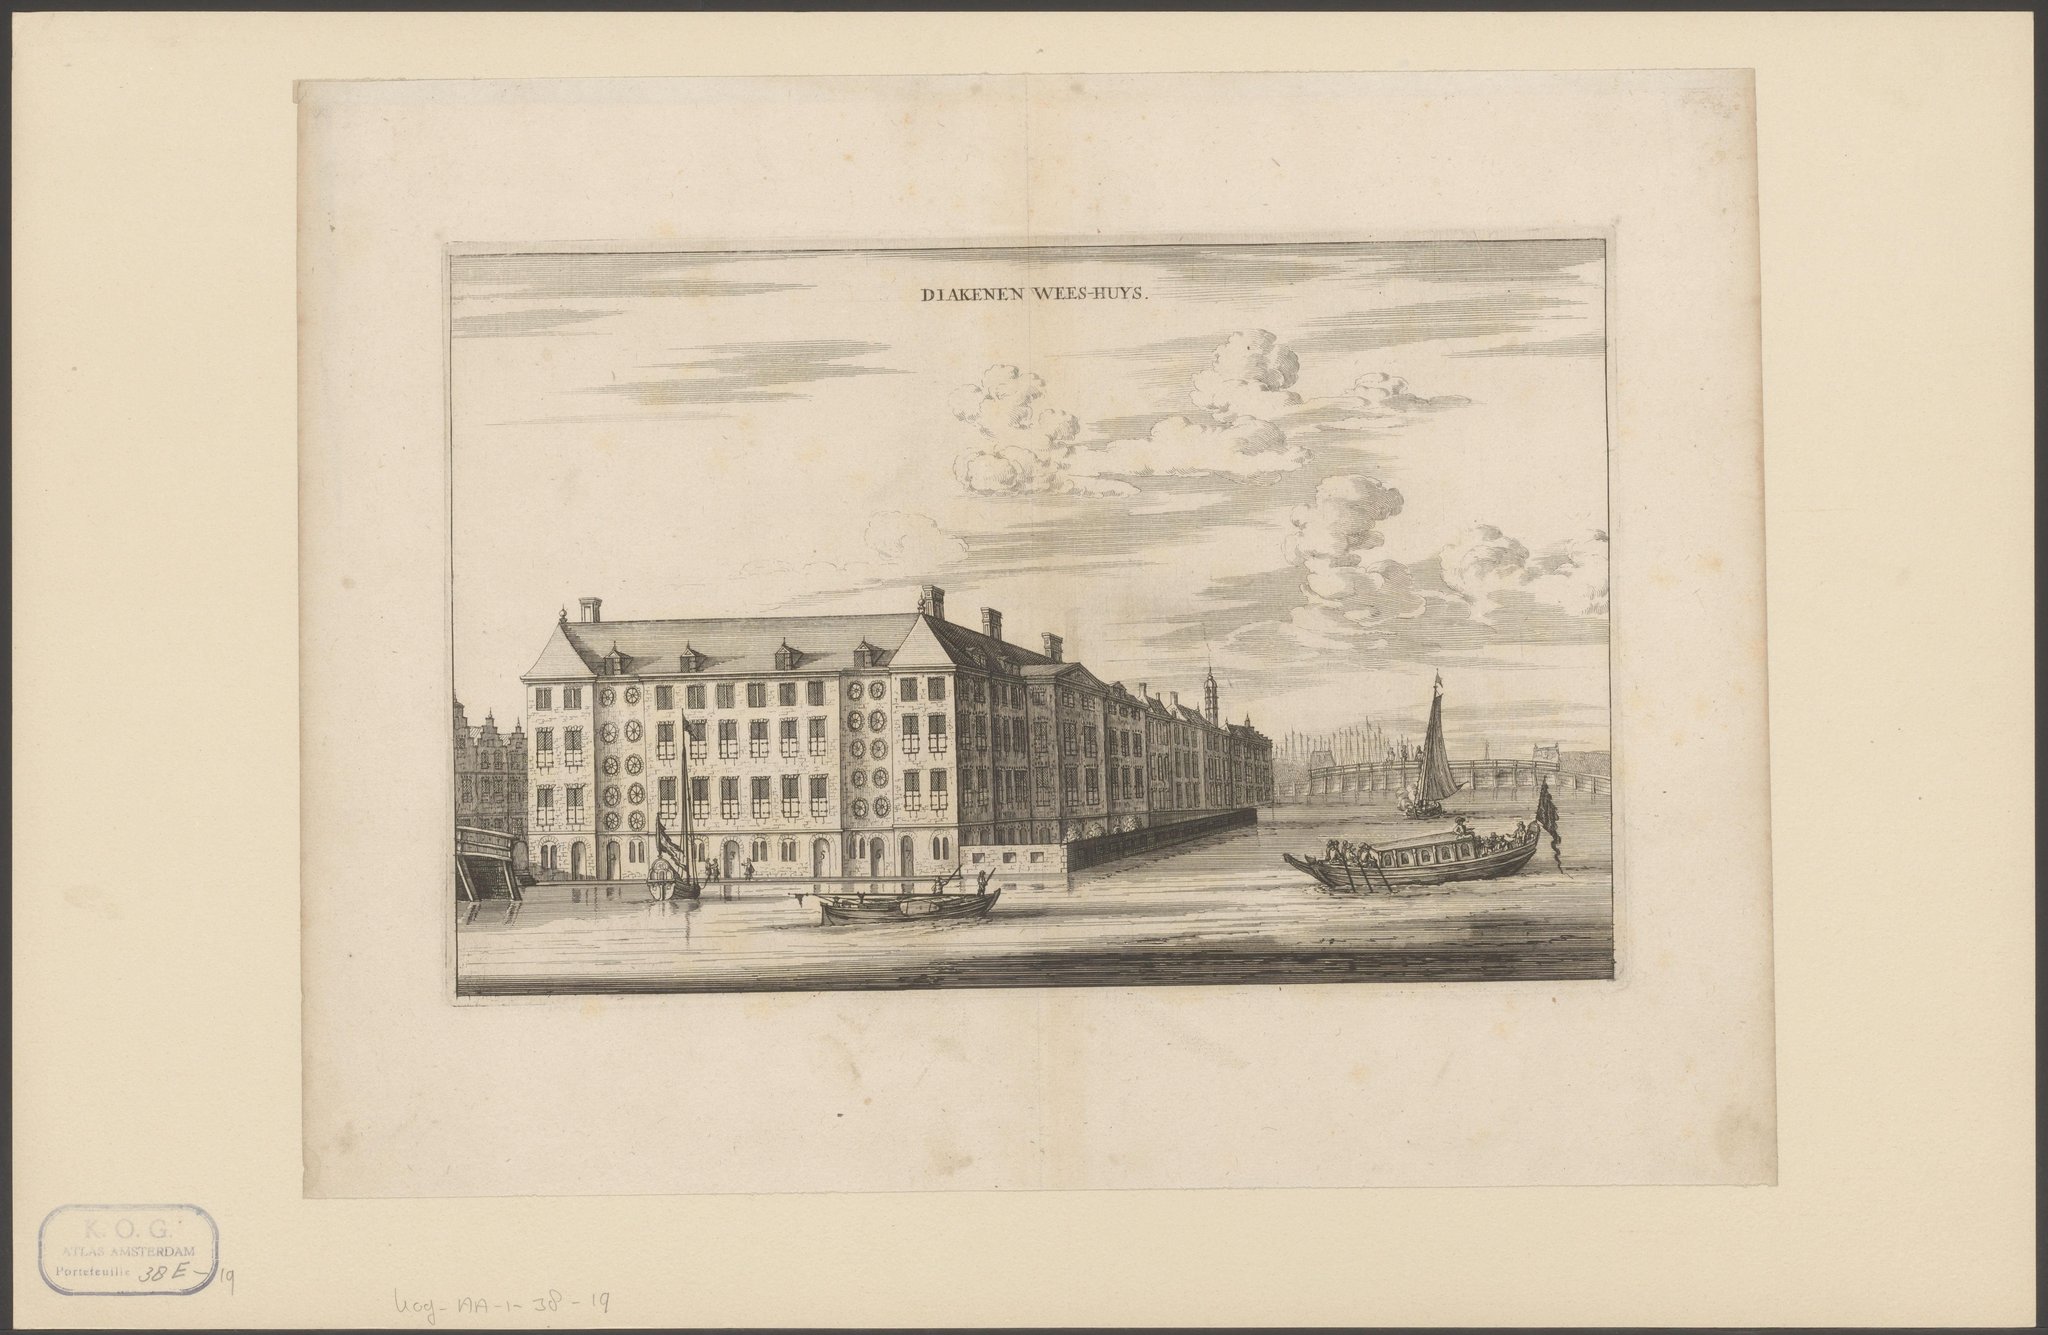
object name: print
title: Diakenen Wees-huys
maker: jacob van meurs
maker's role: draughtsman, print maker, publisher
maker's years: 1619-1680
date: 1663-1664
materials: paper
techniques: engraving, etching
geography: amsterdam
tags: bridge in city across river, canal, etc. (+ city(-scape) with figures, staffage), ships (in general), orphanage, canals, waters (in city) (+ city(-scape) with figures, staffage)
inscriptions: collector's mark: Lugt 1641b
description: Prent mogelijk uit: Dapper, Olfert. Historische beschryving der stadt Amsterdam (…). Amsterdam: Jacob van Meurs, 1663. Of uit: Zesen, Philipp von. Beschreibung der Stadt Amsterdam (…). Amsterdam: Joachim Nosche, 1664. Bij sommige exemplaren van eerstgenoemde uitgave werd een latere staat ingebonden waarop boven de Nederlandse titel ook een Franse is toegevoegd.